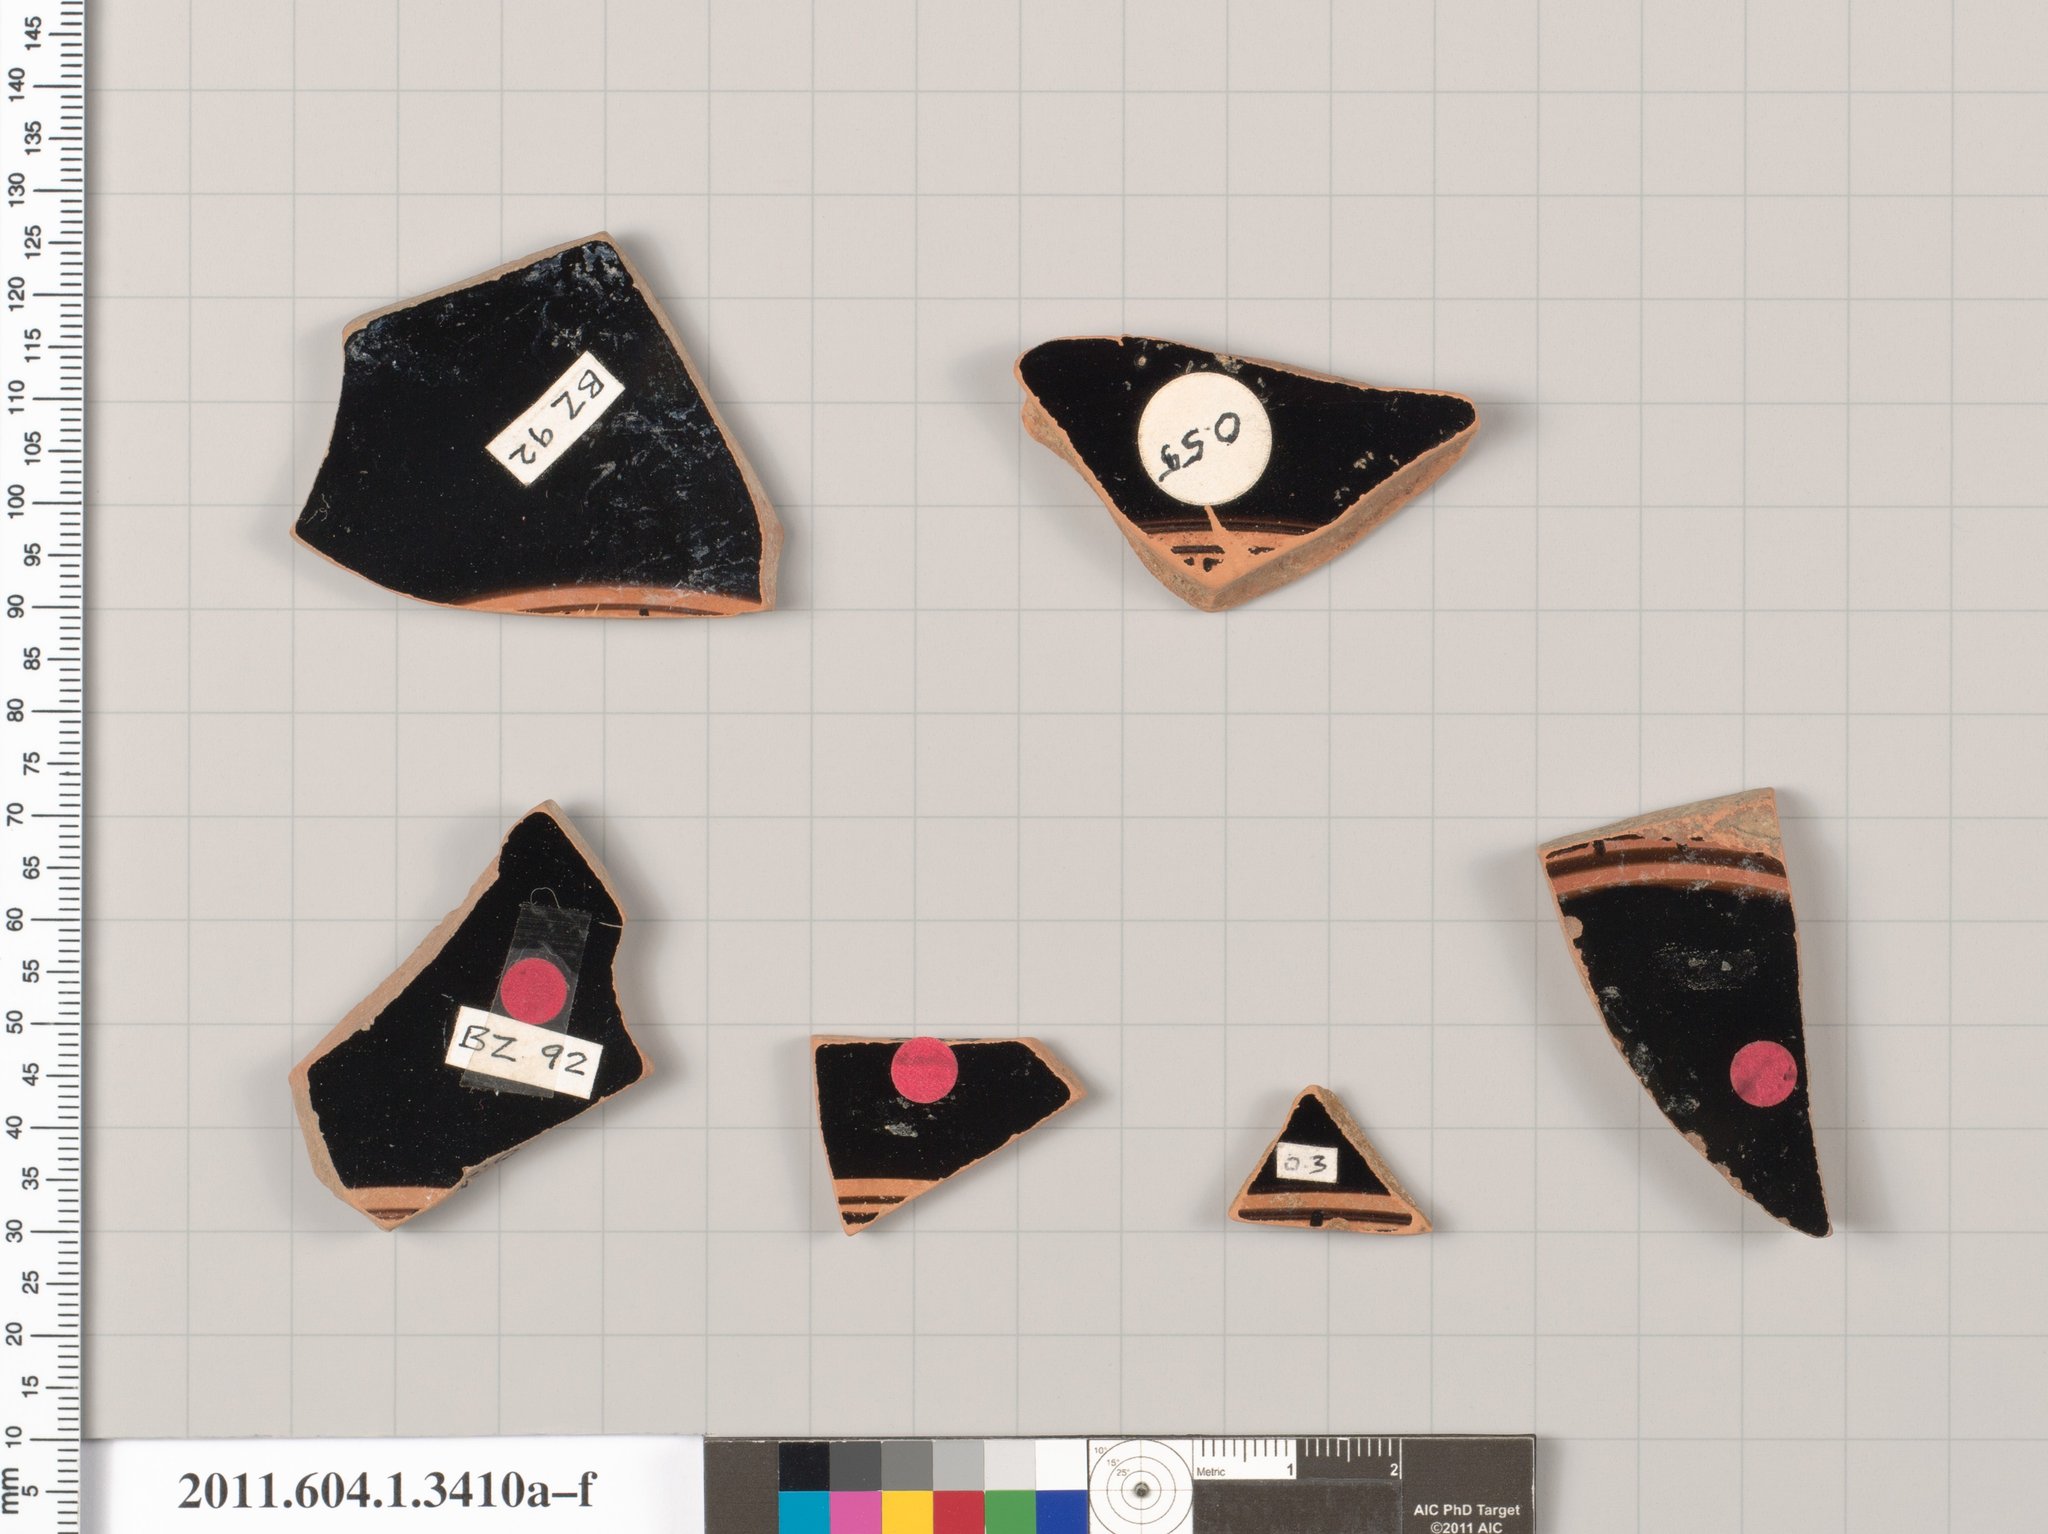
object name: kylix fragment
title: Terracotta fragments of kylikes (drinking cups)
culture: greek, attic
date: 510-470 BCE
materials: terracotta